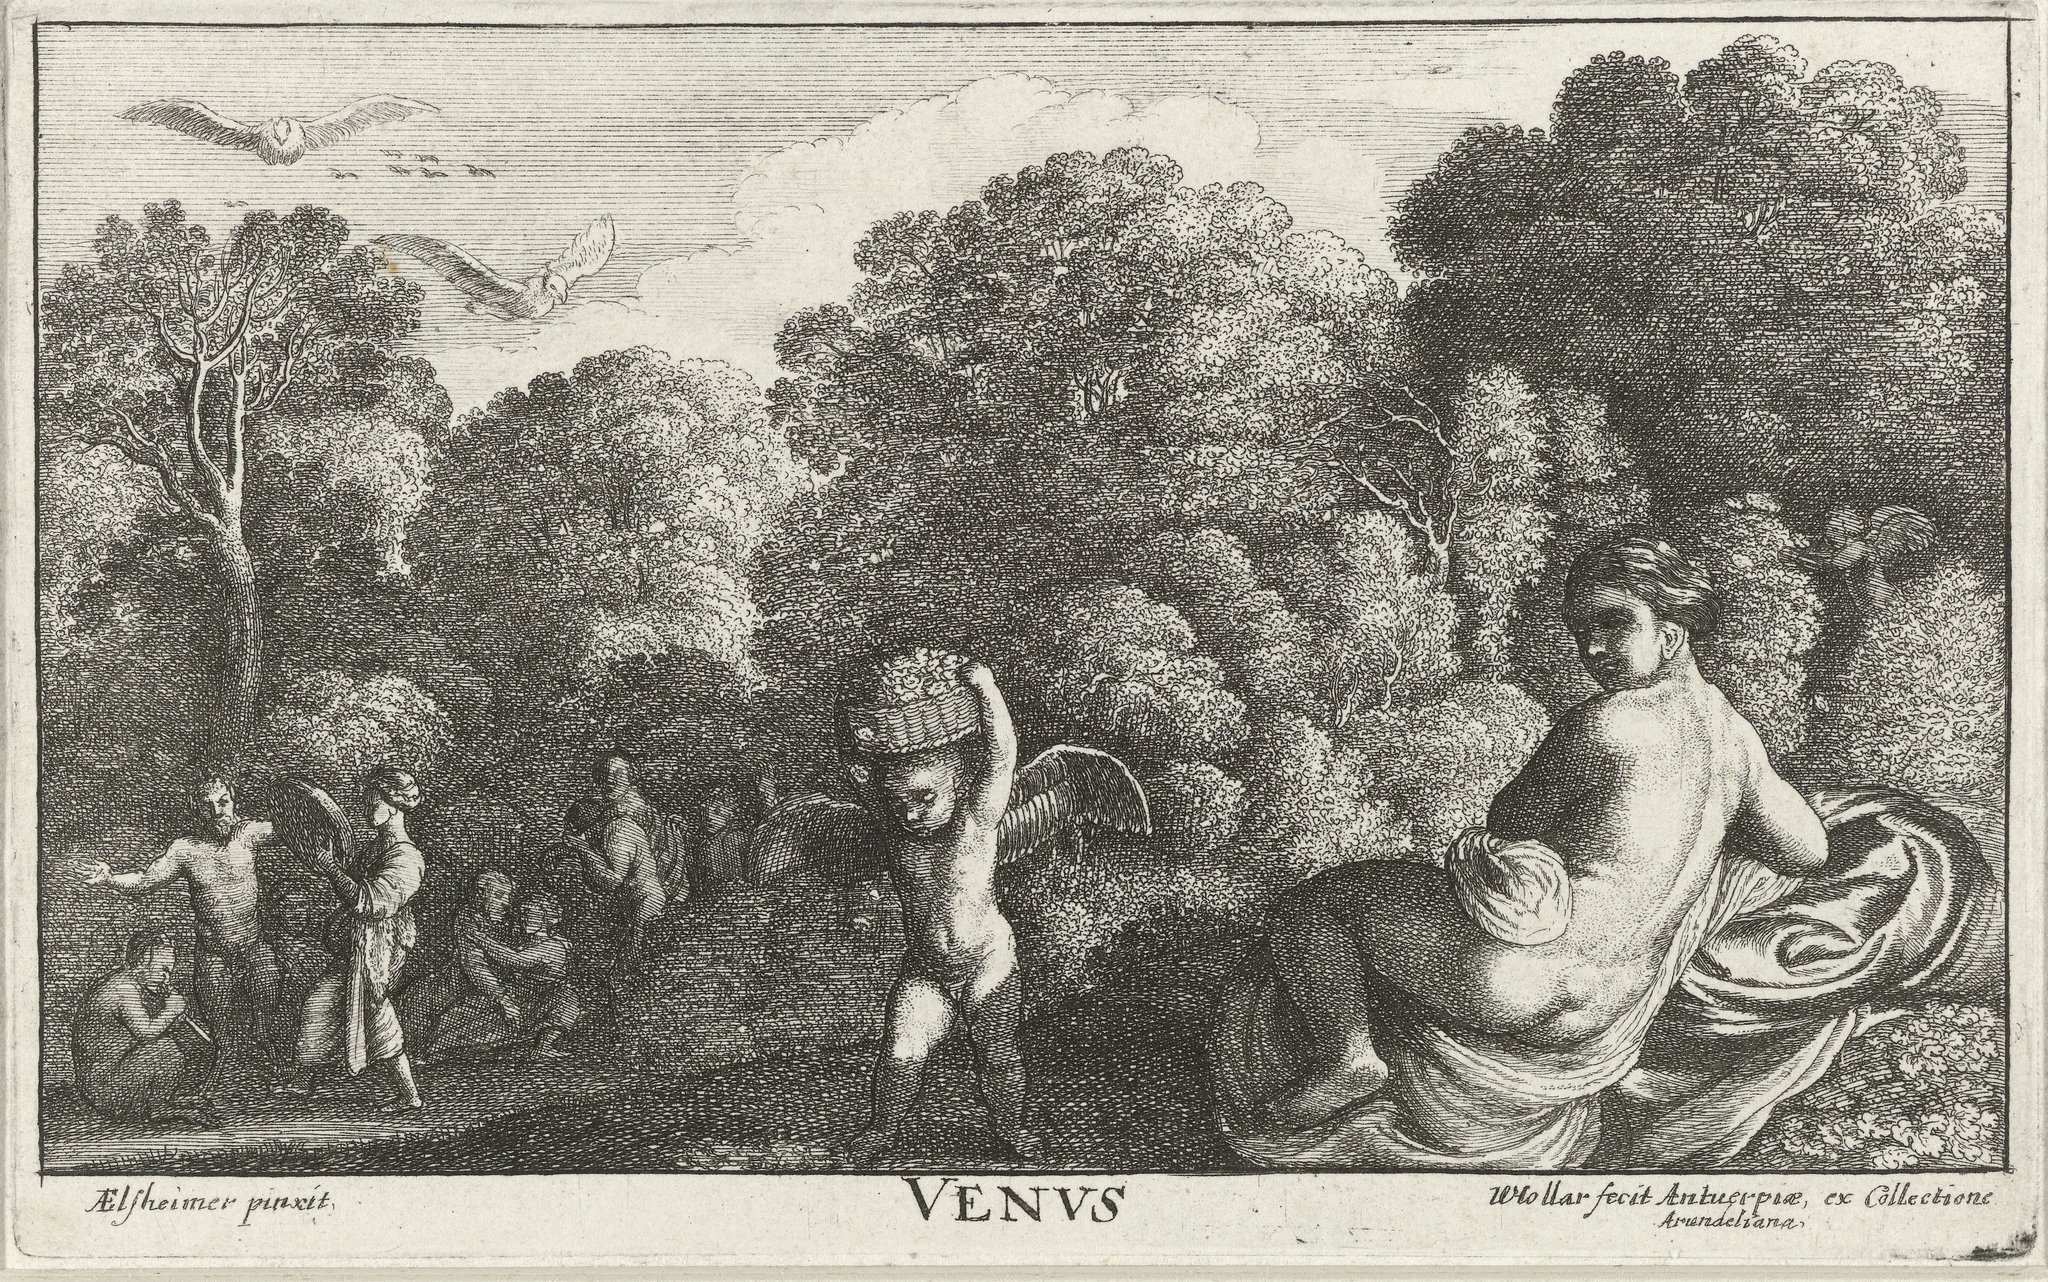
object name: print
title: De drie wereldrijken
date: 1646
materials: paper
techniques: etching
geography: antwerp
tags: (story of) venus (aphrodite)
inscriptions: collector's mark: Lugt 240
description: Venus zit in een landschap samen met Amor, nimfen en saters.